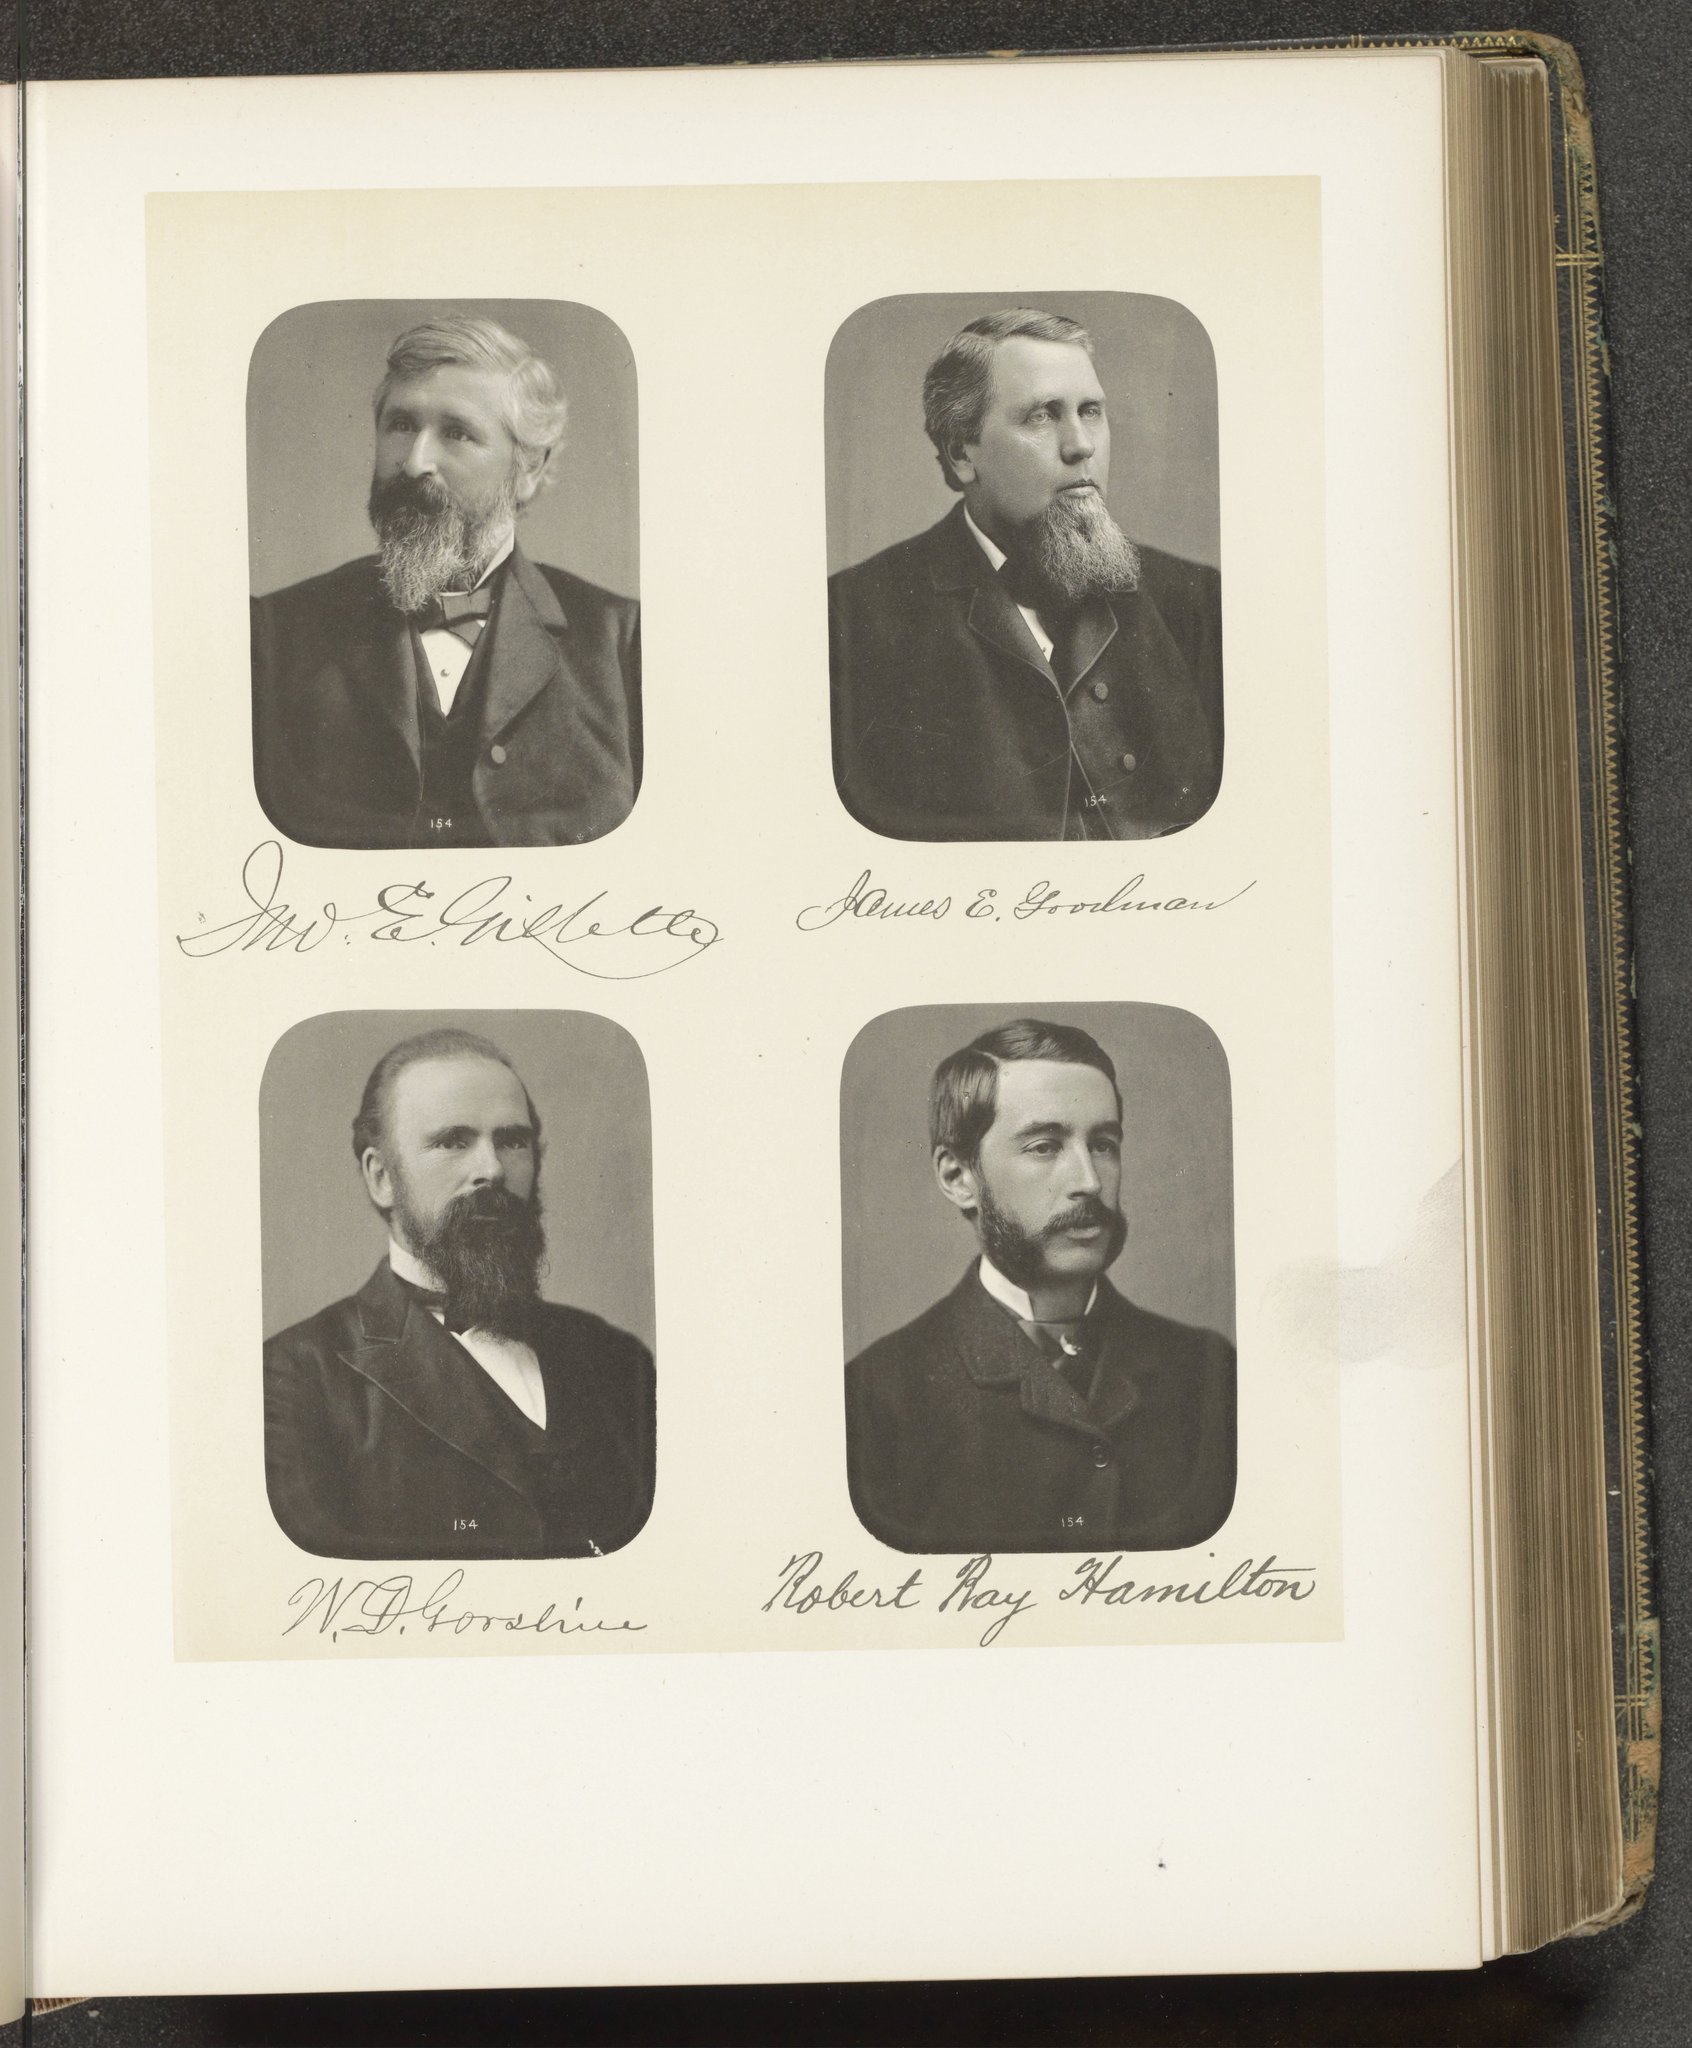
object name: page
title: Portretten van vier leden van het Lagerhuis van de staat New York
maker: Anonymous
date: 1872-1882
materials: paper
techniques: photograph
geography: united states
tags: historical persons (portraits and scenes from the life) (+ head (and shoulders) (portrait))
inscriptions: annotation, number: ‘152’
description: Linksboven David G. Evans, rechtsboven Samuel H. Everett, linksonder James Fanning, rechtsonder Milton M. Fenner.